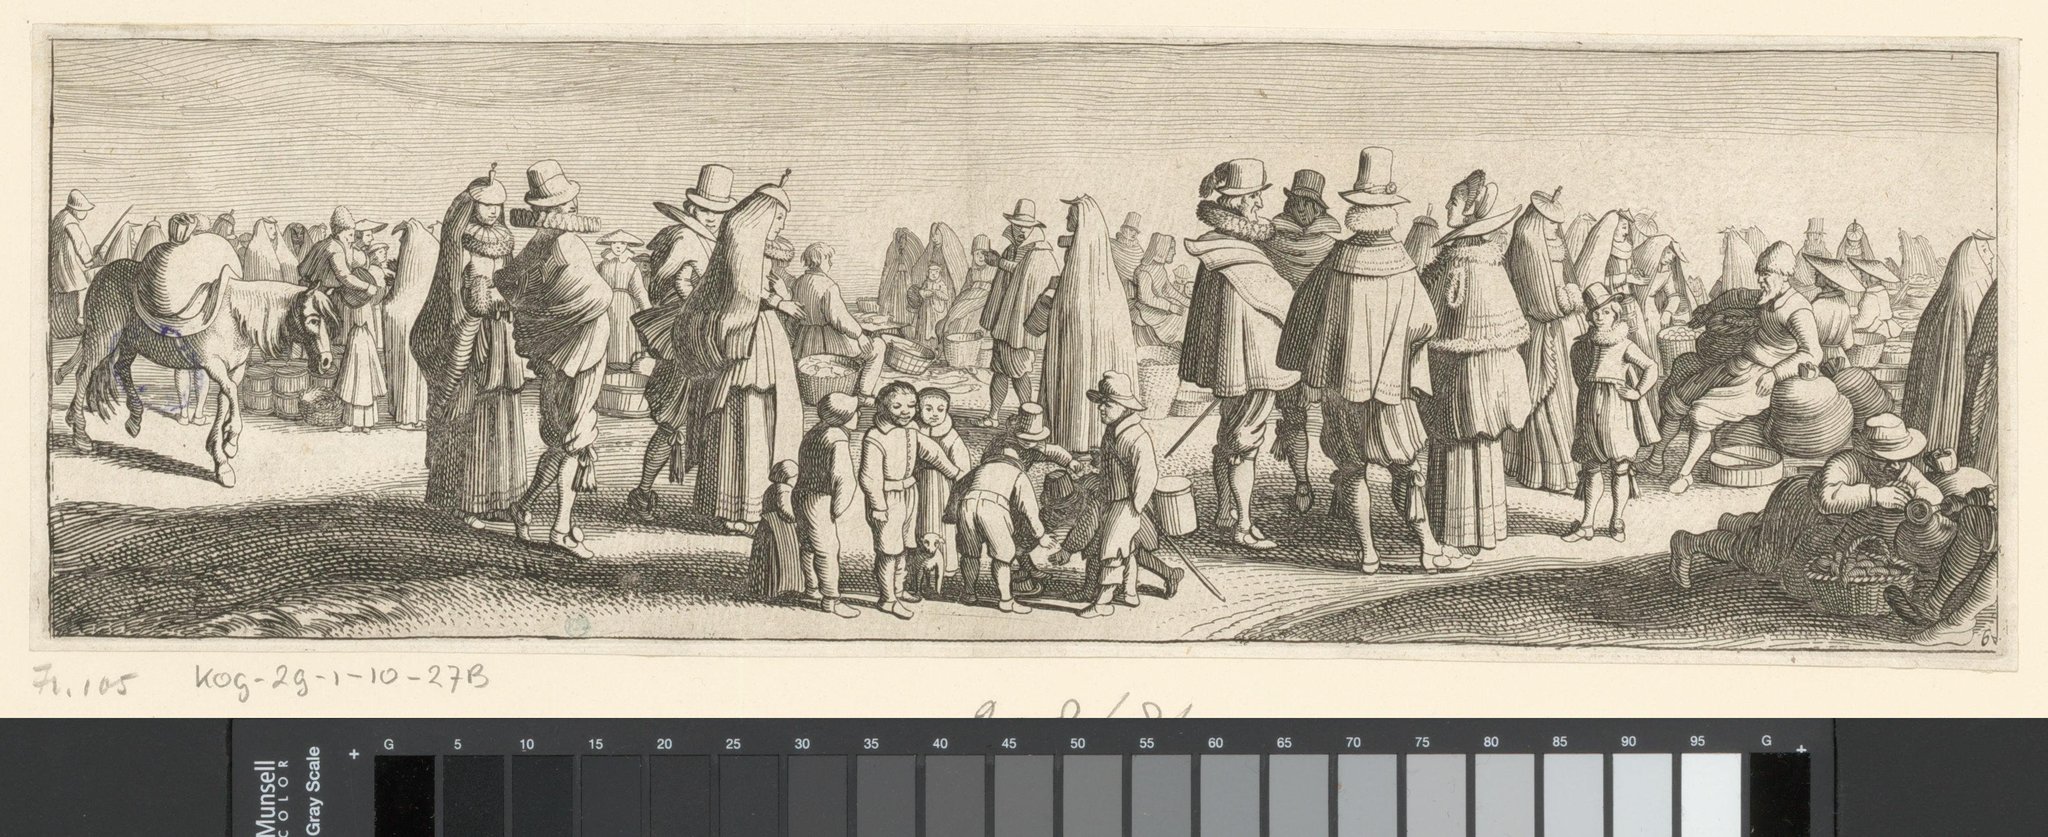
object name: print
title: Markttafereel met spelende kinderen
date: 1603-1652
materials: paper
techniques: engraving, etching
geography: amsterdam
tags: children's games and plays, market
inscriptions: collector's mark: Lugt 1934, stamp, collector's mark: Lugt 1641, collector's mark: Lugt 5100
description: Markt, met spelende kinderen op de voorgrond. Op het tweede plan groepjes elegant geklede dames en heren bij marktverkopers. Rechtsvoor een slapende markkoopman bij een mand; achter hem een koopman zittend tussen zakken koopwaar. Tweede prent van een fries bestaande uit vier prenten, voorstellende een markt. Zesde prent uit de totale serie markten (serie markt A + B). Rechts genummerd: 6. Onderwerpsrubrieken binnen de Atlas Zeden en Gewoonten: Handel, nijverheid en verkeer, Marktwezen, Markttafereelen, Marktfiguren.